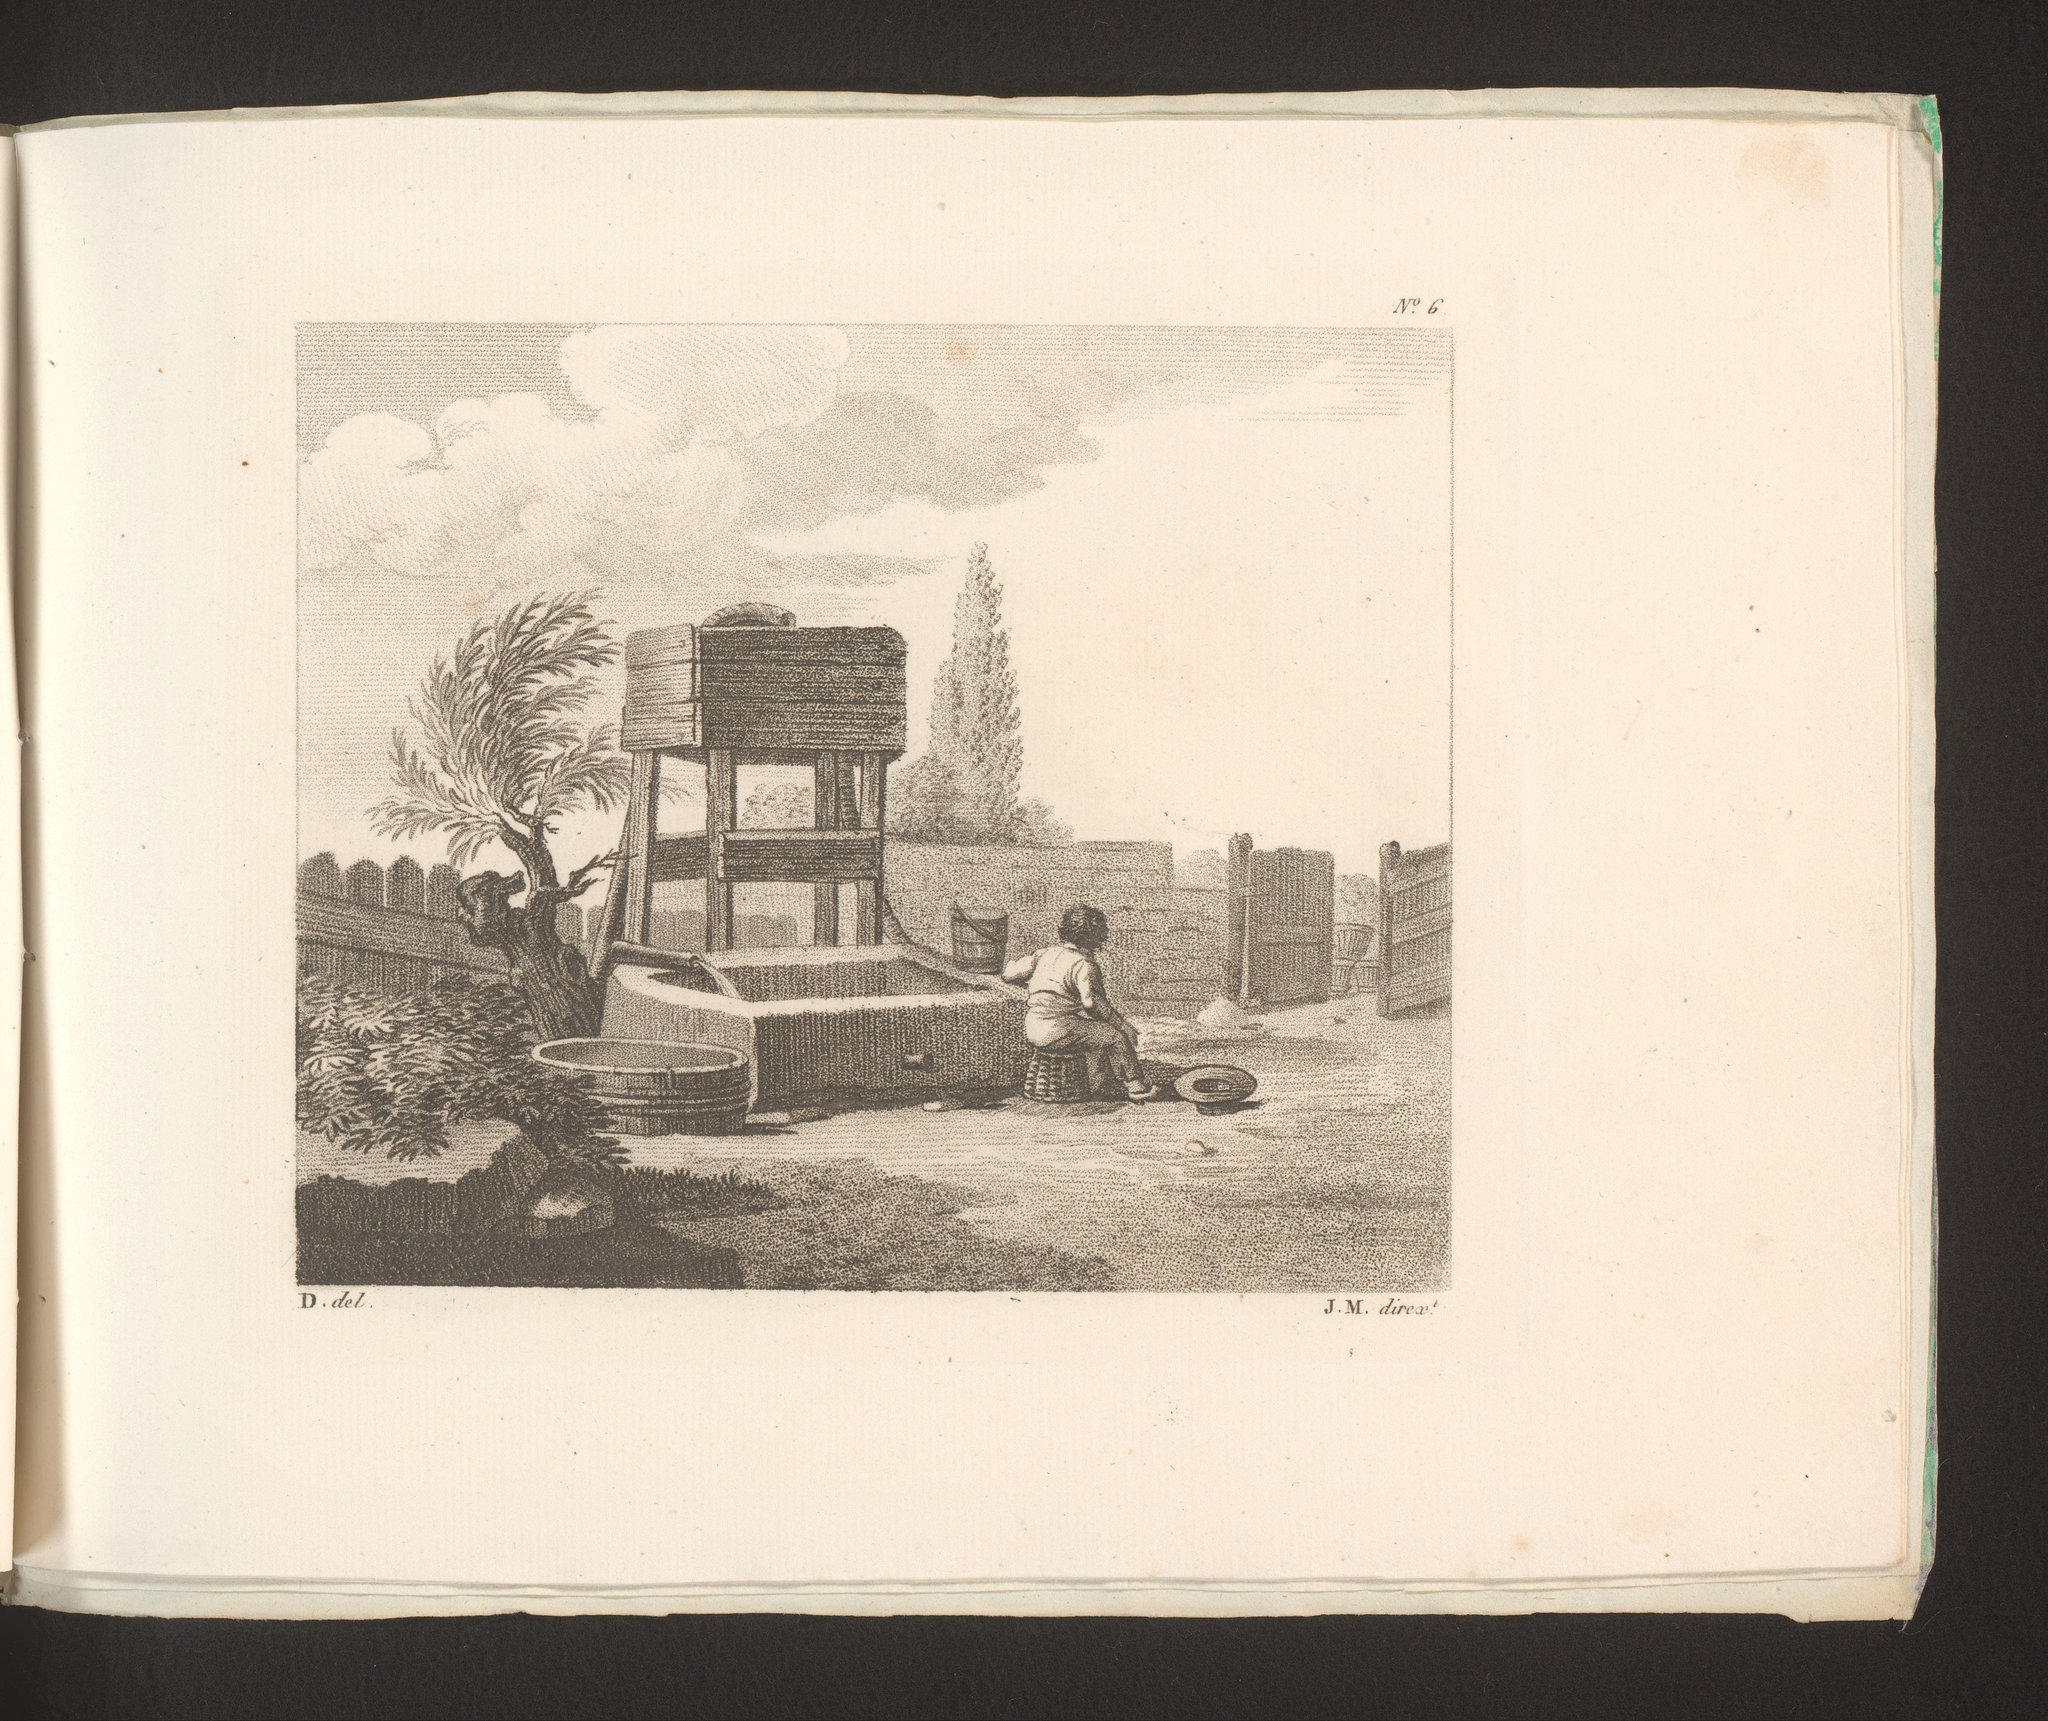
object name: album leaf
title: Tekenvoorbeelden, tweede schrift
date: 1800-1825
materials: paper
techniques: printmaking, engraving, etching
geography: paris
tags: trough, well, boy (child between toddler and youth)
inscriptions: collector's mark: Lugt 2228, collector's mark: Lugt 2760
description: Deze prent maakt deel uit van een album.